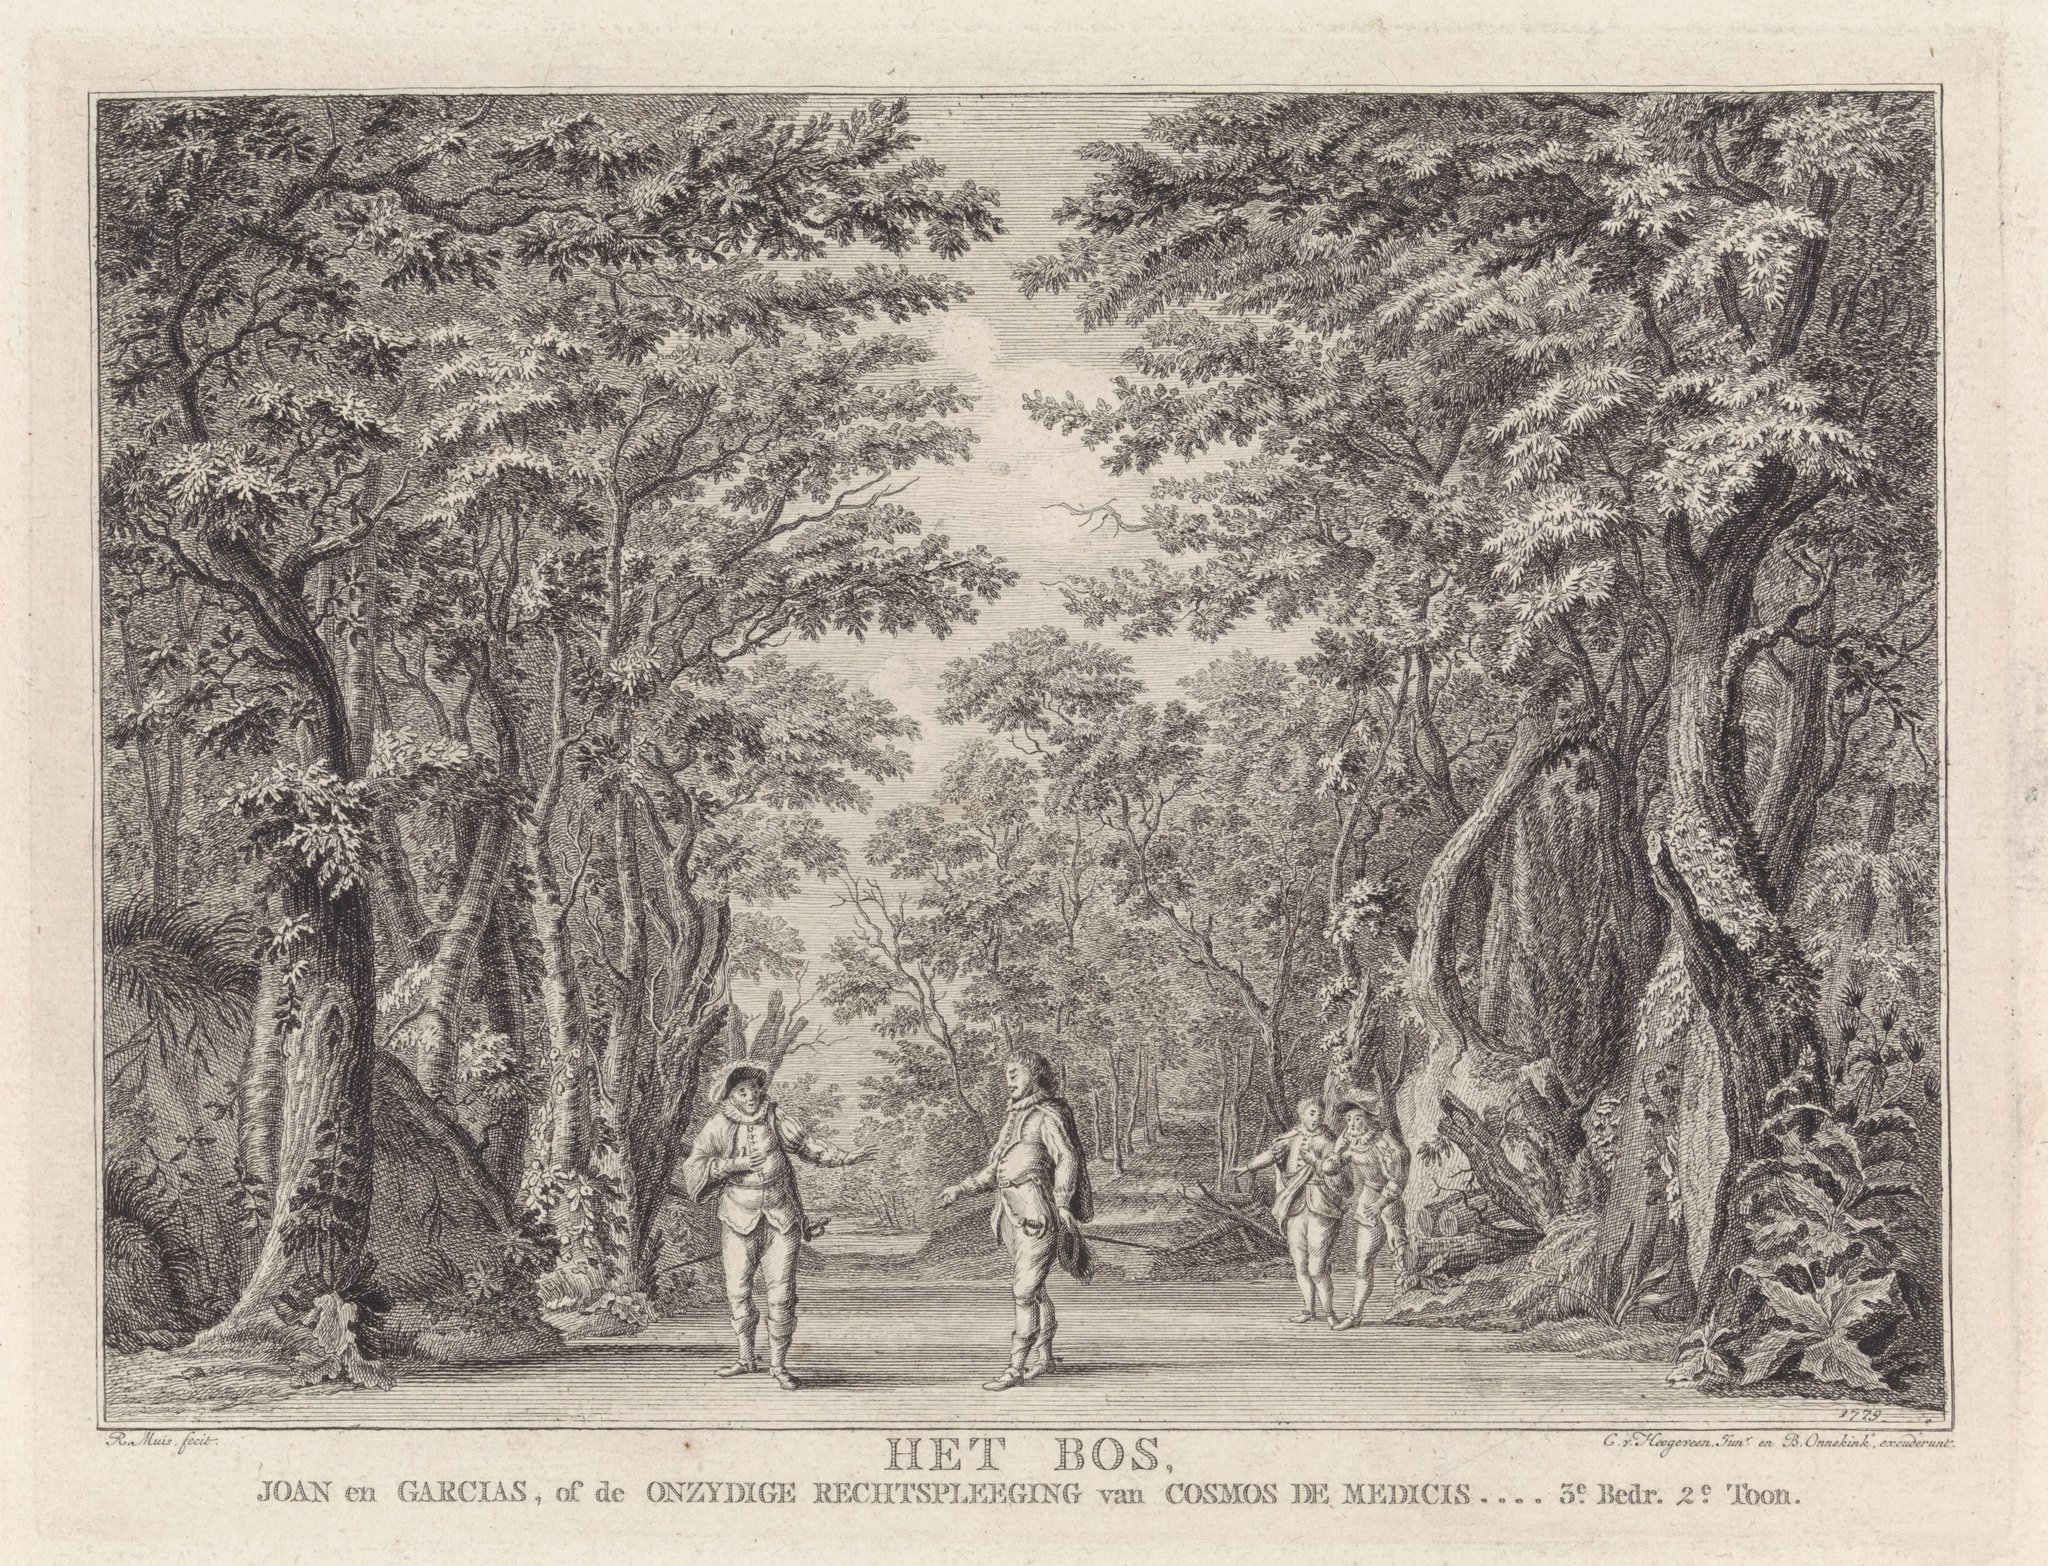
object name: print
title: De dood van Johan en Garcias: Vier mannen in het bos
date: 1779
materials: paper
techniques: etching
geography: leiden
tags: theatre, theatrical performance, forest, wood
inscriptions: collector's mark: Lugt 2228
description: Twee mannen voeren een gesprek op de voorgrond. Rechtsachter twee mannen. De prent verbeeldt een toneelscène uit De dood van Johan en Garcias, of De onzydige regtspleeging van Cosmos de Medicis; groothertog van Toscanen, een treurspel van Claas Bruin.